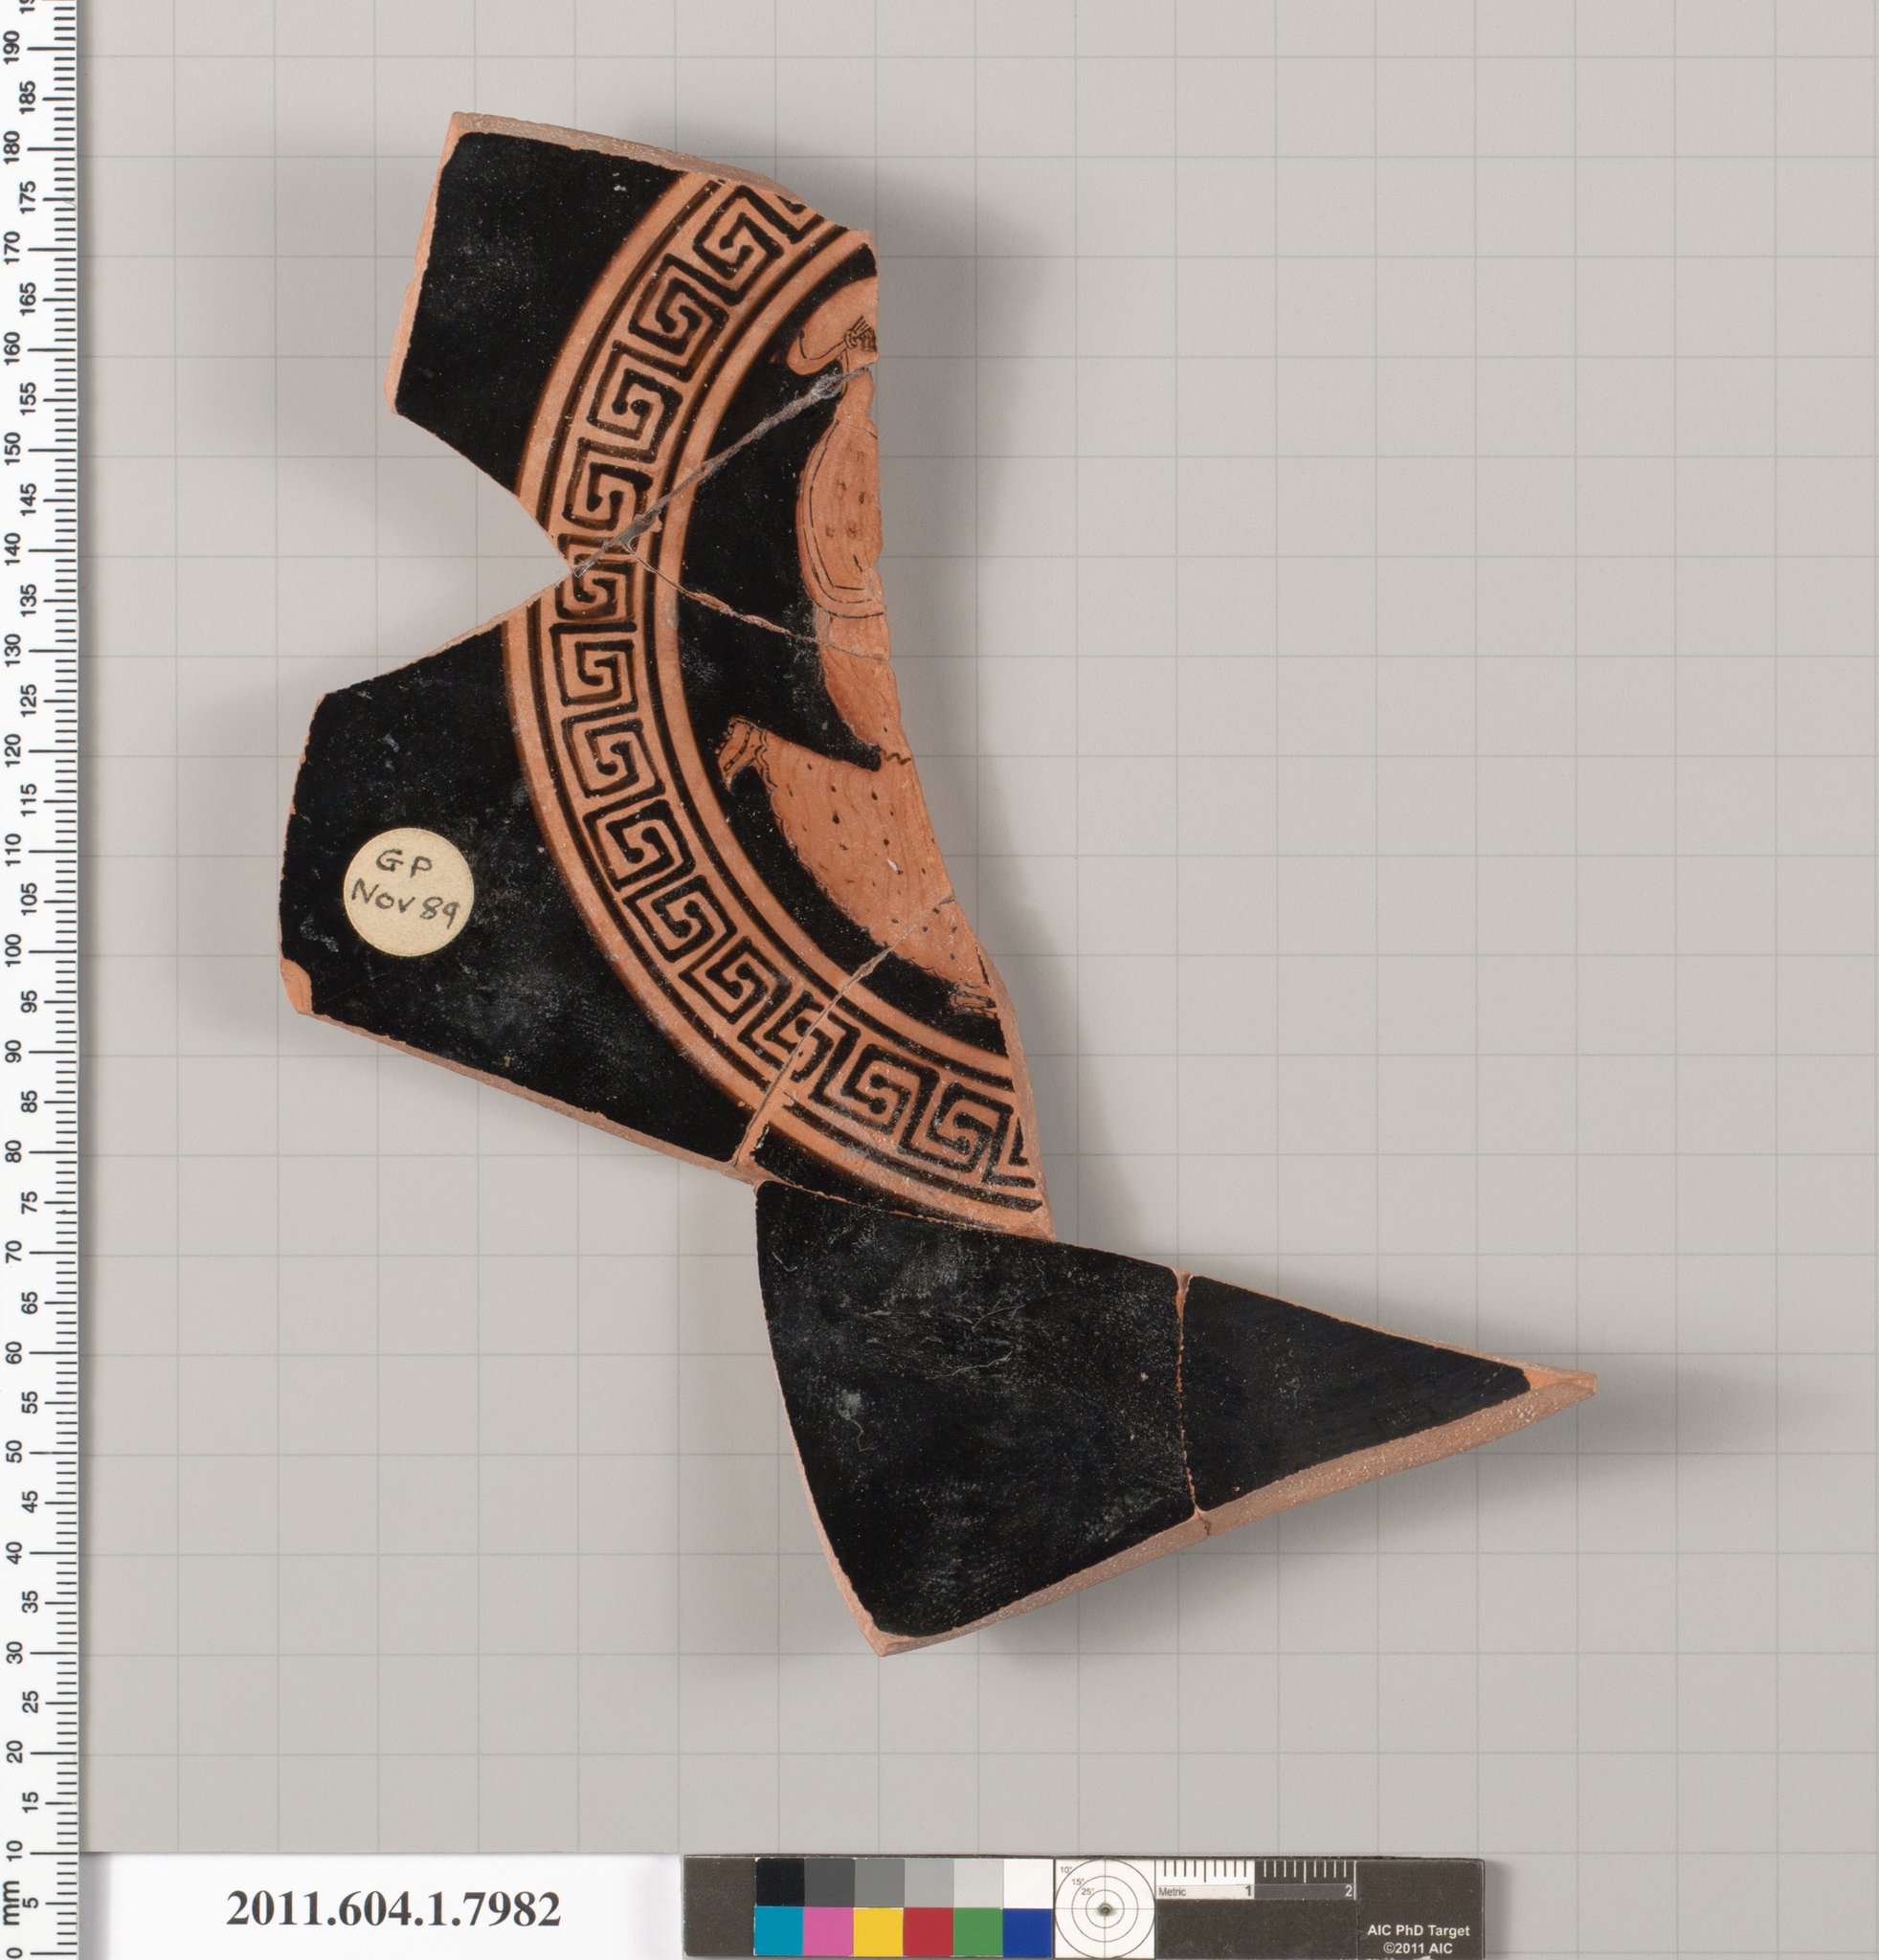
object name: kylix fragment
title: Terracotta fragment of a kylix (drinking cup)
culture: greek, attic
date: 475-451 BCE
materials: terracotta